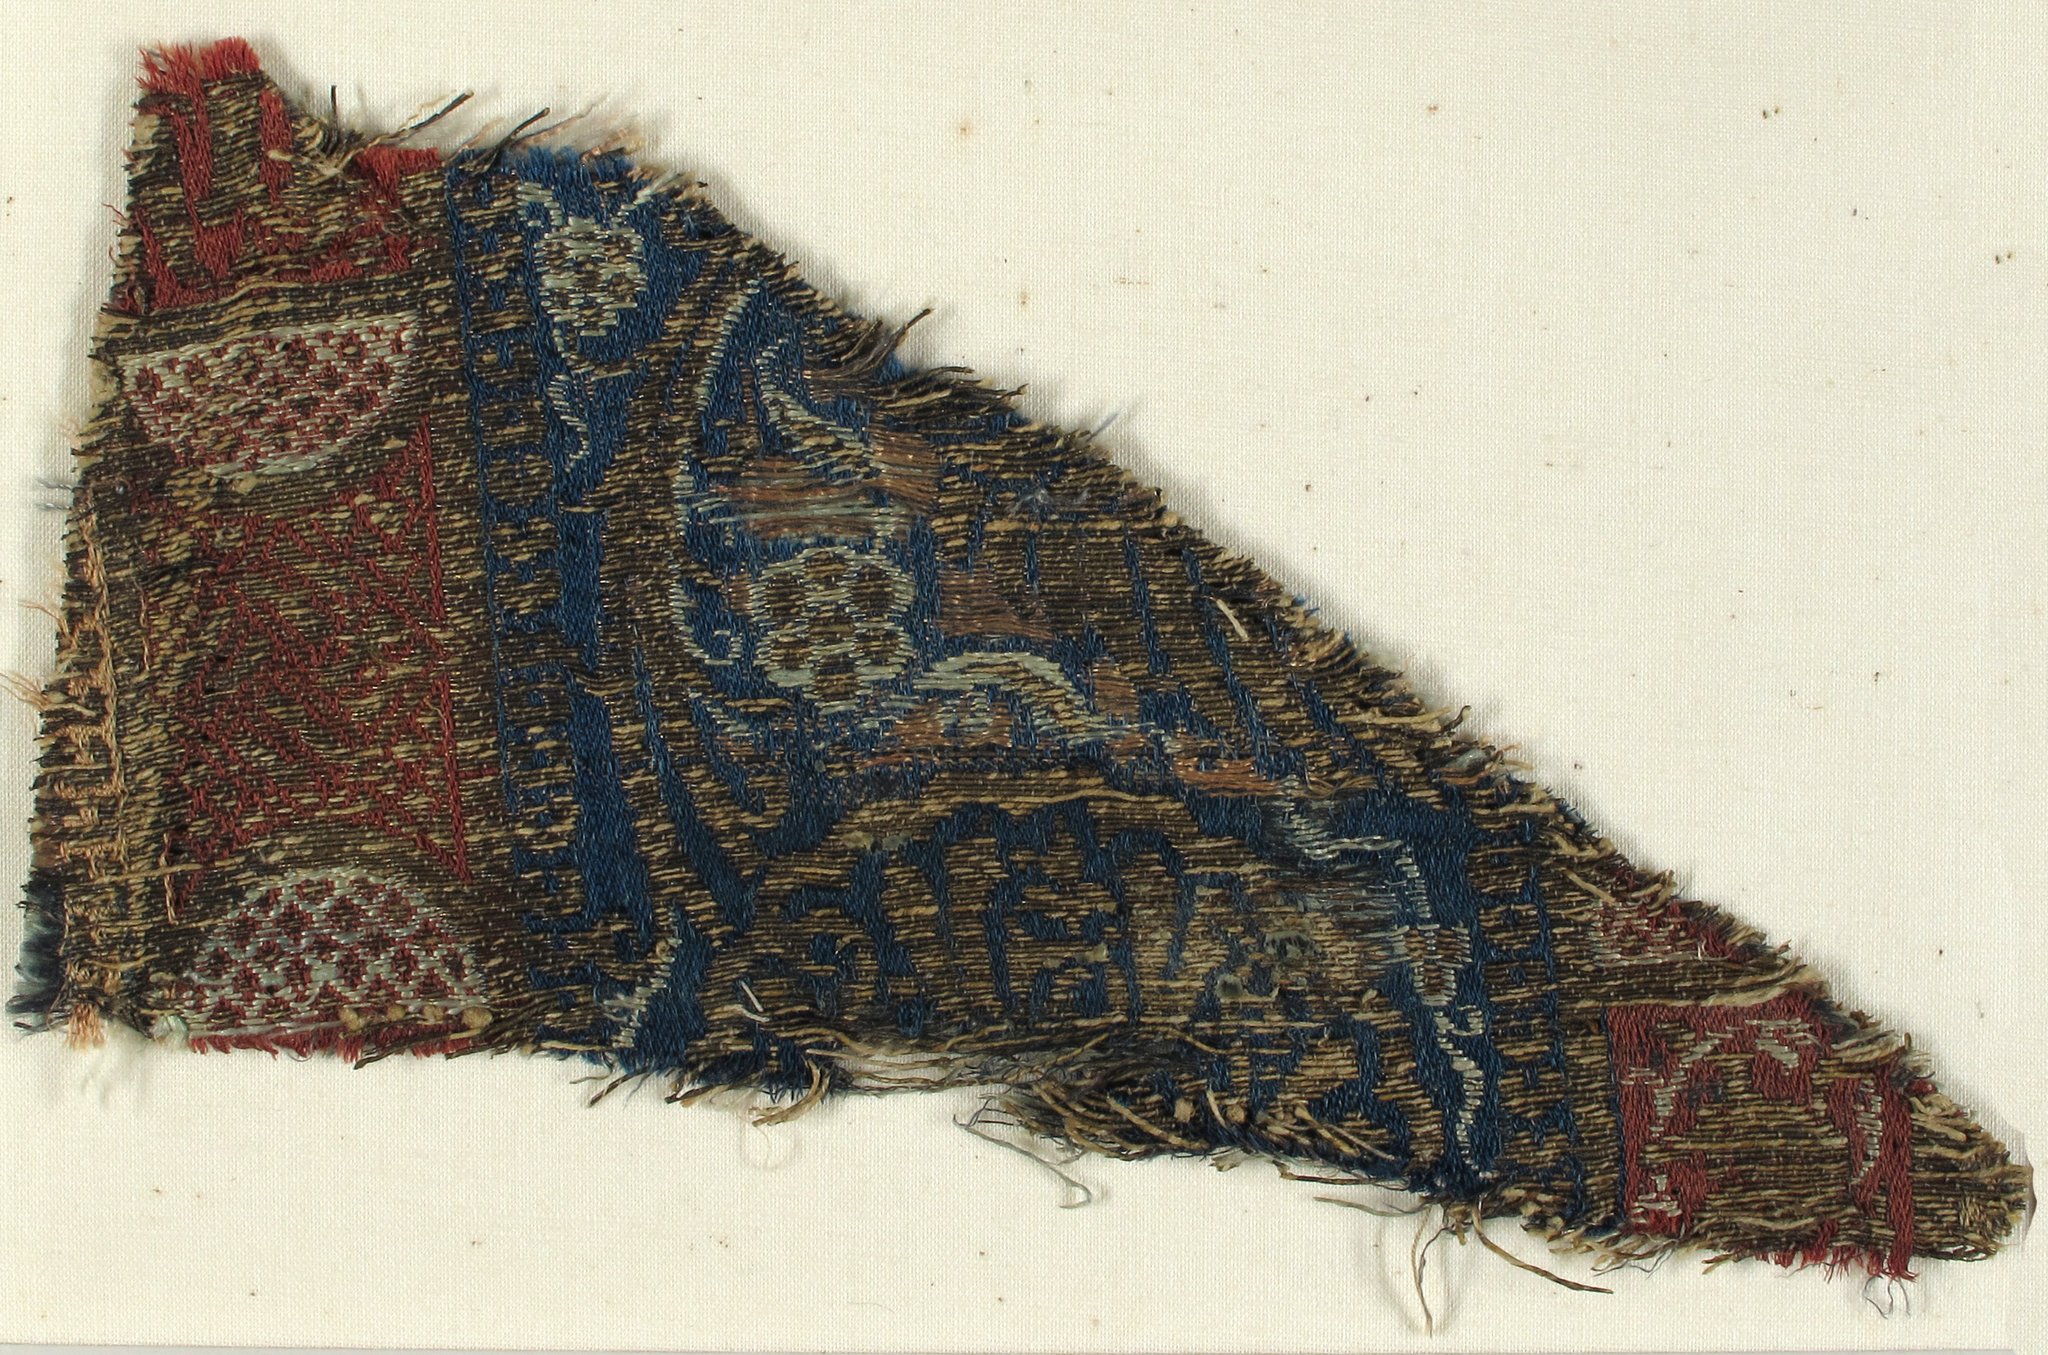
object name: textile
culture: italian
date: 1301-1400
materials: gilt, silk, thread